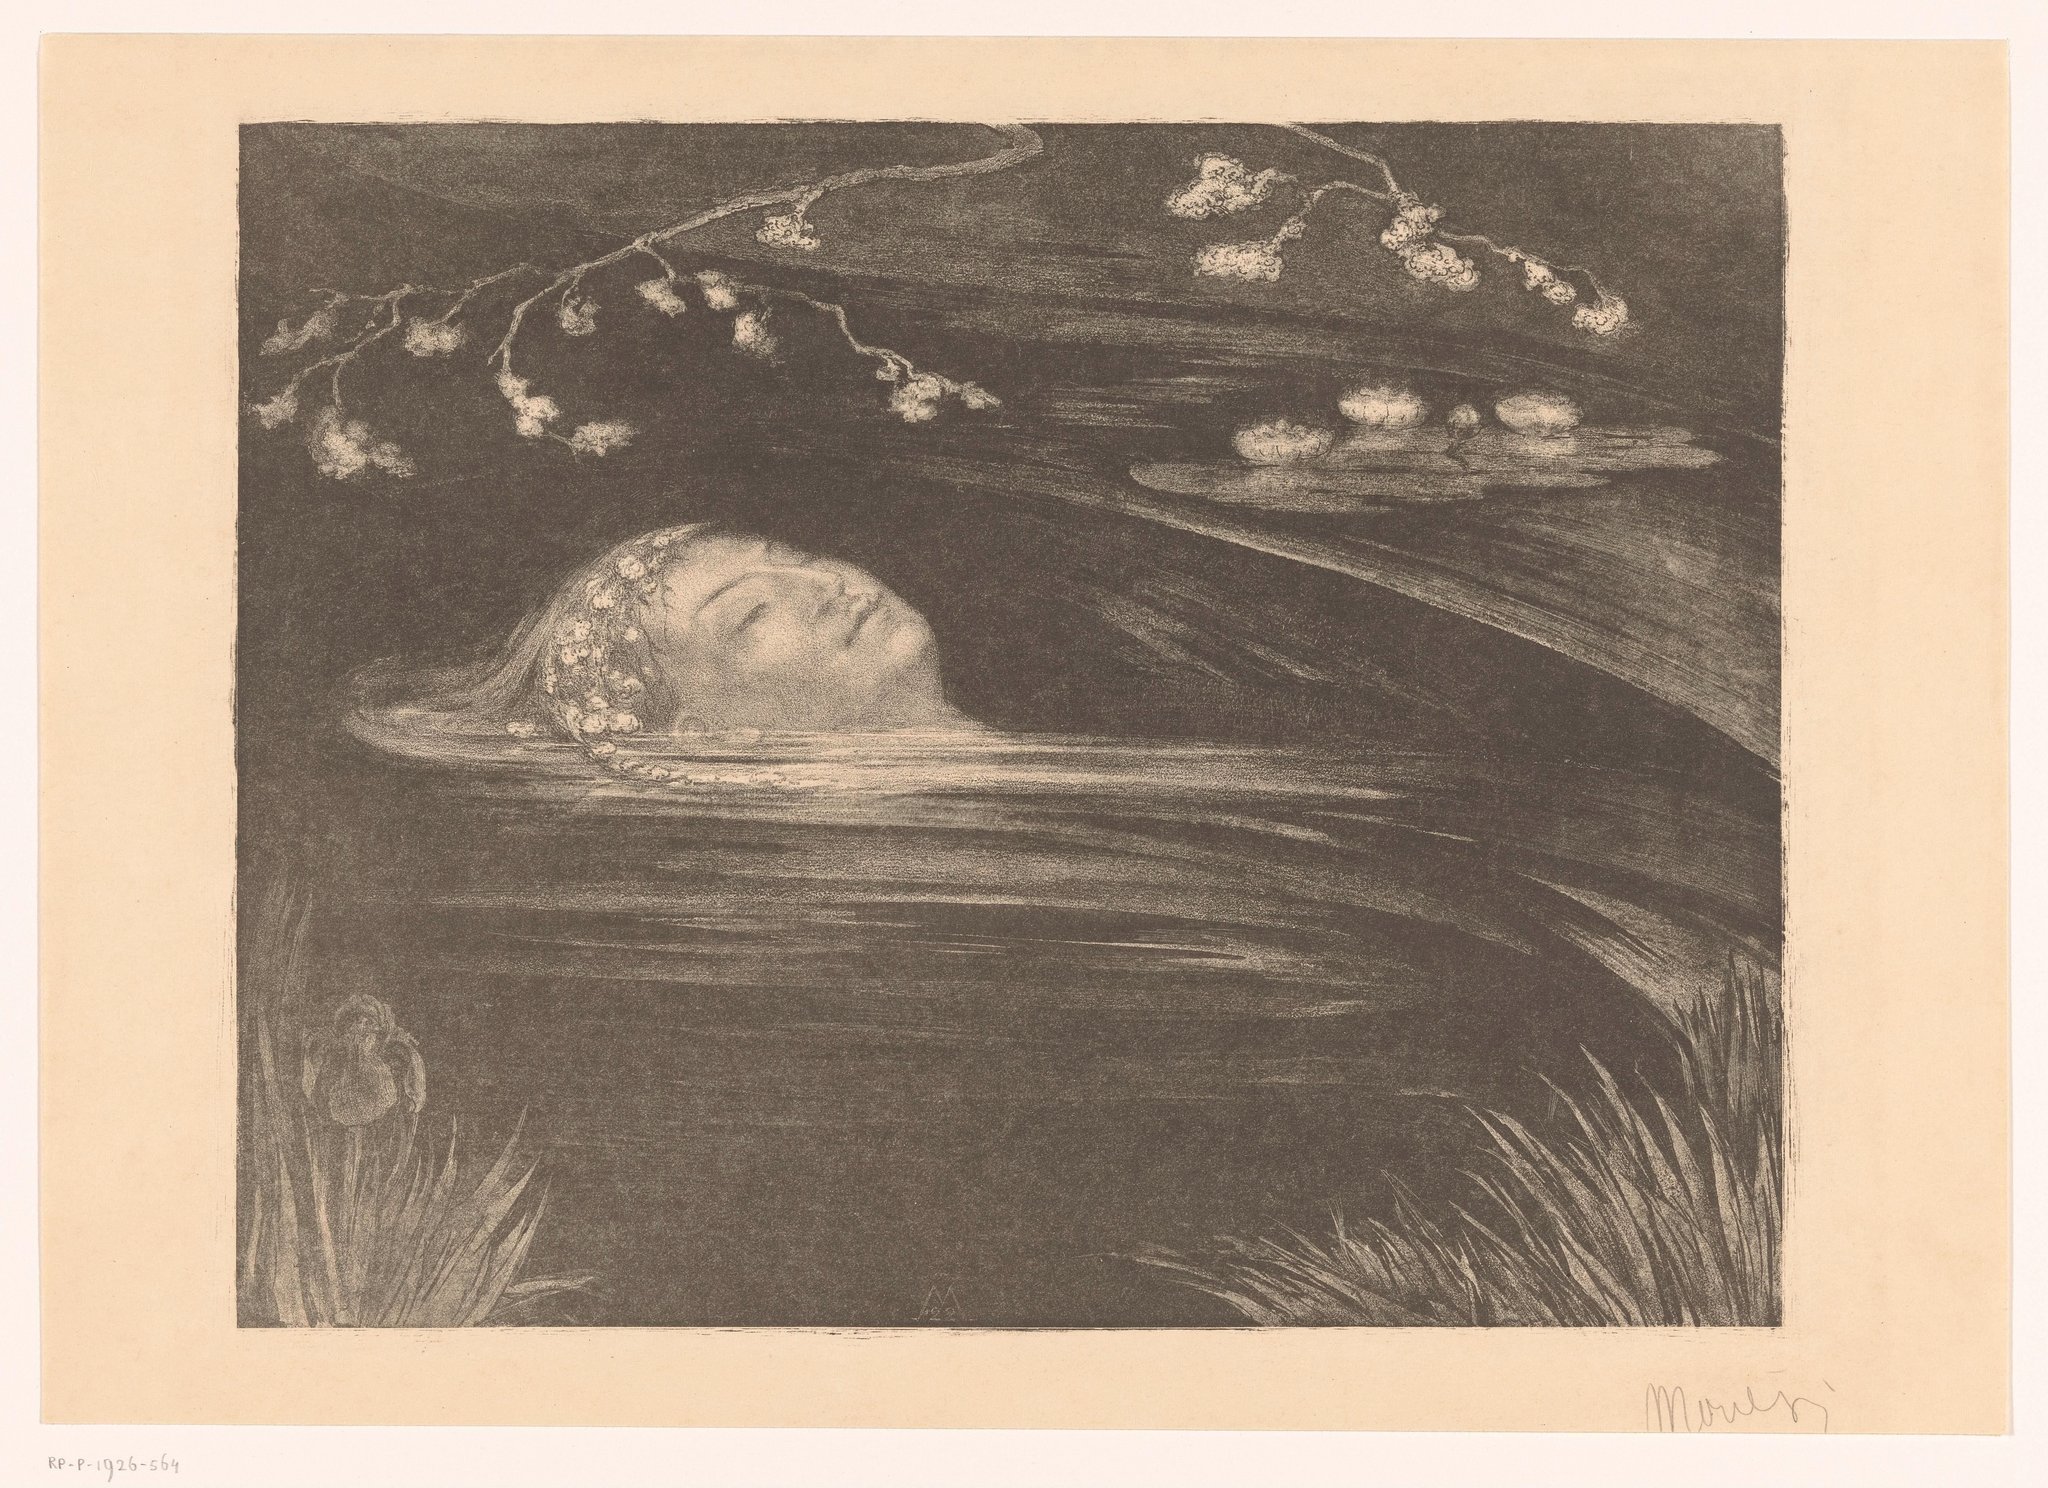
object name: print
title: Ophelia drijvend in het water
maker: simon moulijn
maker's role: draughtsman, print maker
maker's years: 1866-1948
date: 1922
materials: paper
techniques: lithograph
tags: ophelia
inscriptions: collector's mark: Lugt 2228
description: De verdronken Ophelia drijft in het water.